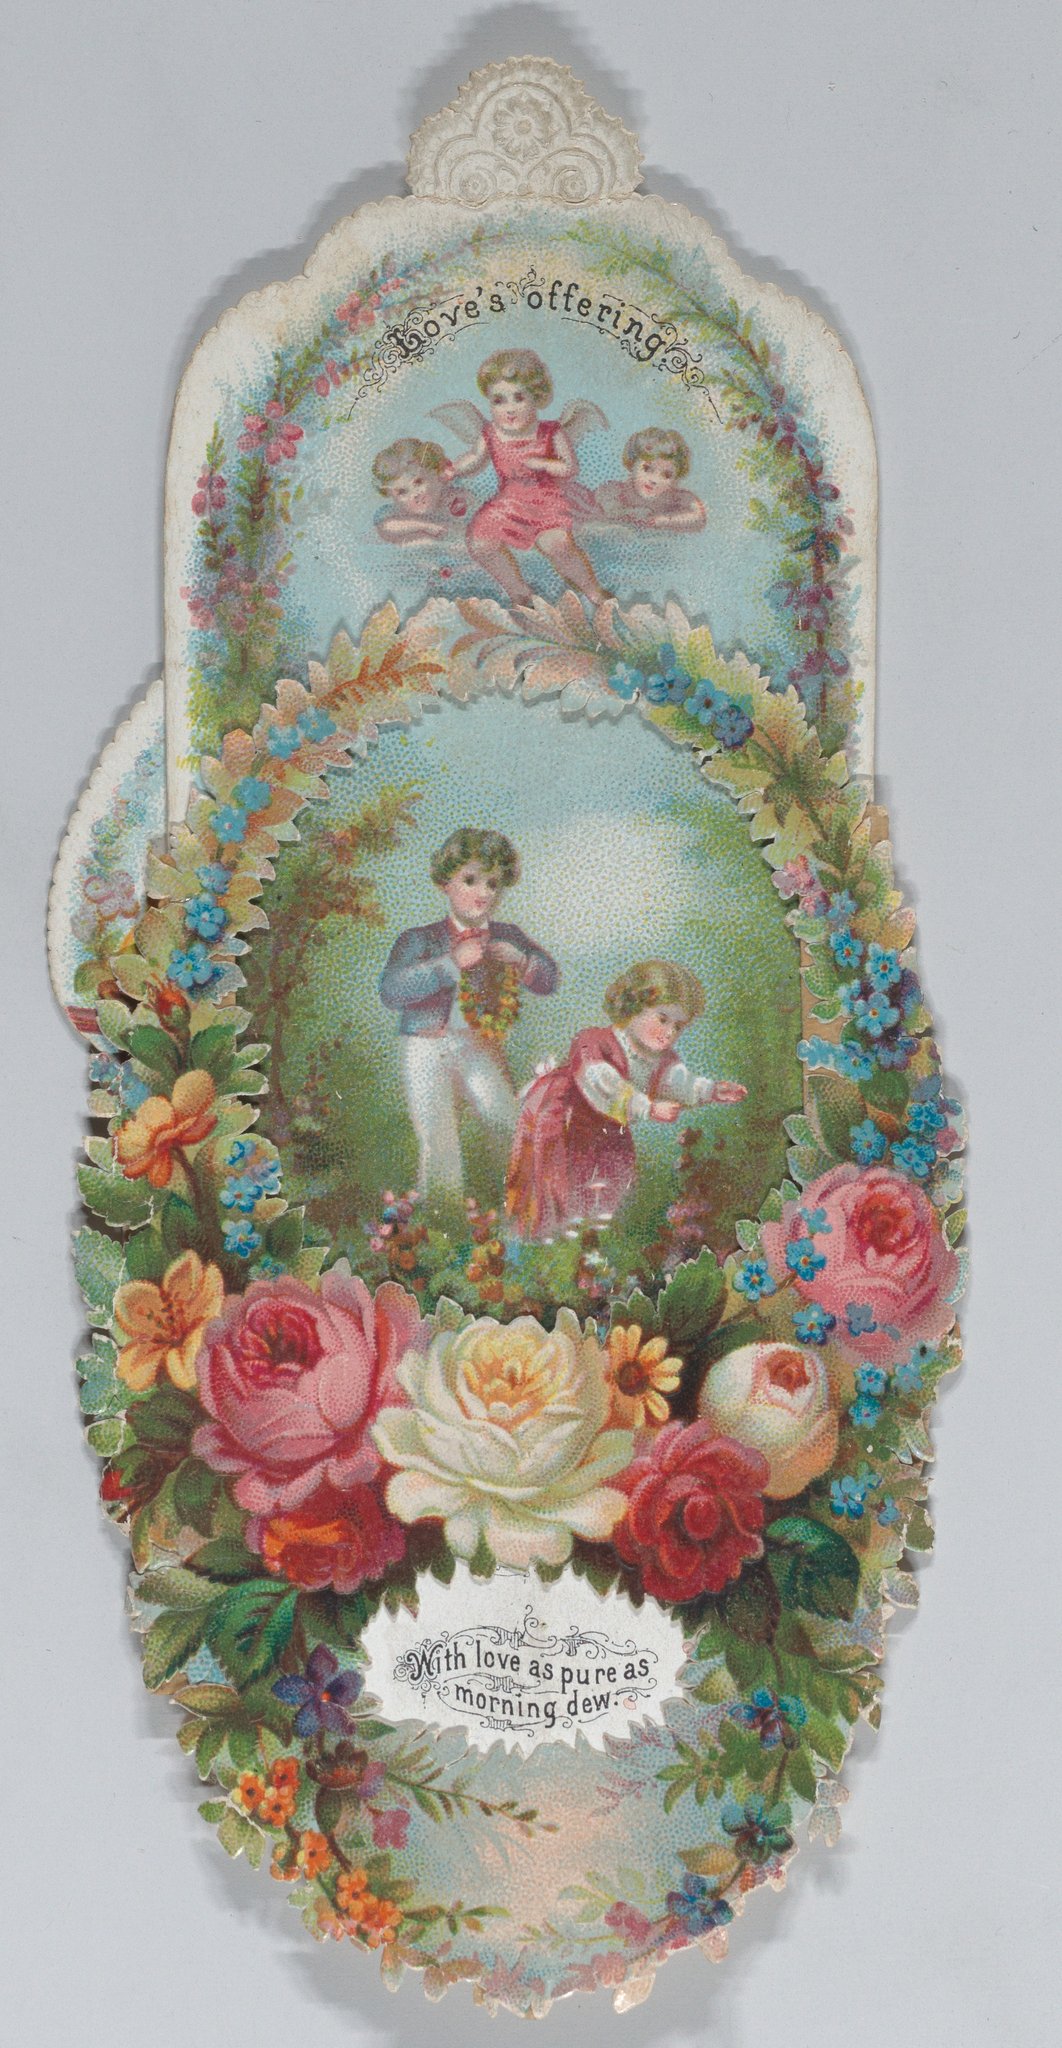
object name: valentine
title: Valentine - Mechanical - romantic symbolism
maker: anonymous, british, 19th century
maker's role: artist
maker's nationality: british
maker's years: 1800-1900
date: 1875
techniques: chromolithography, cutting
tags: boys,girls,flowers,angels